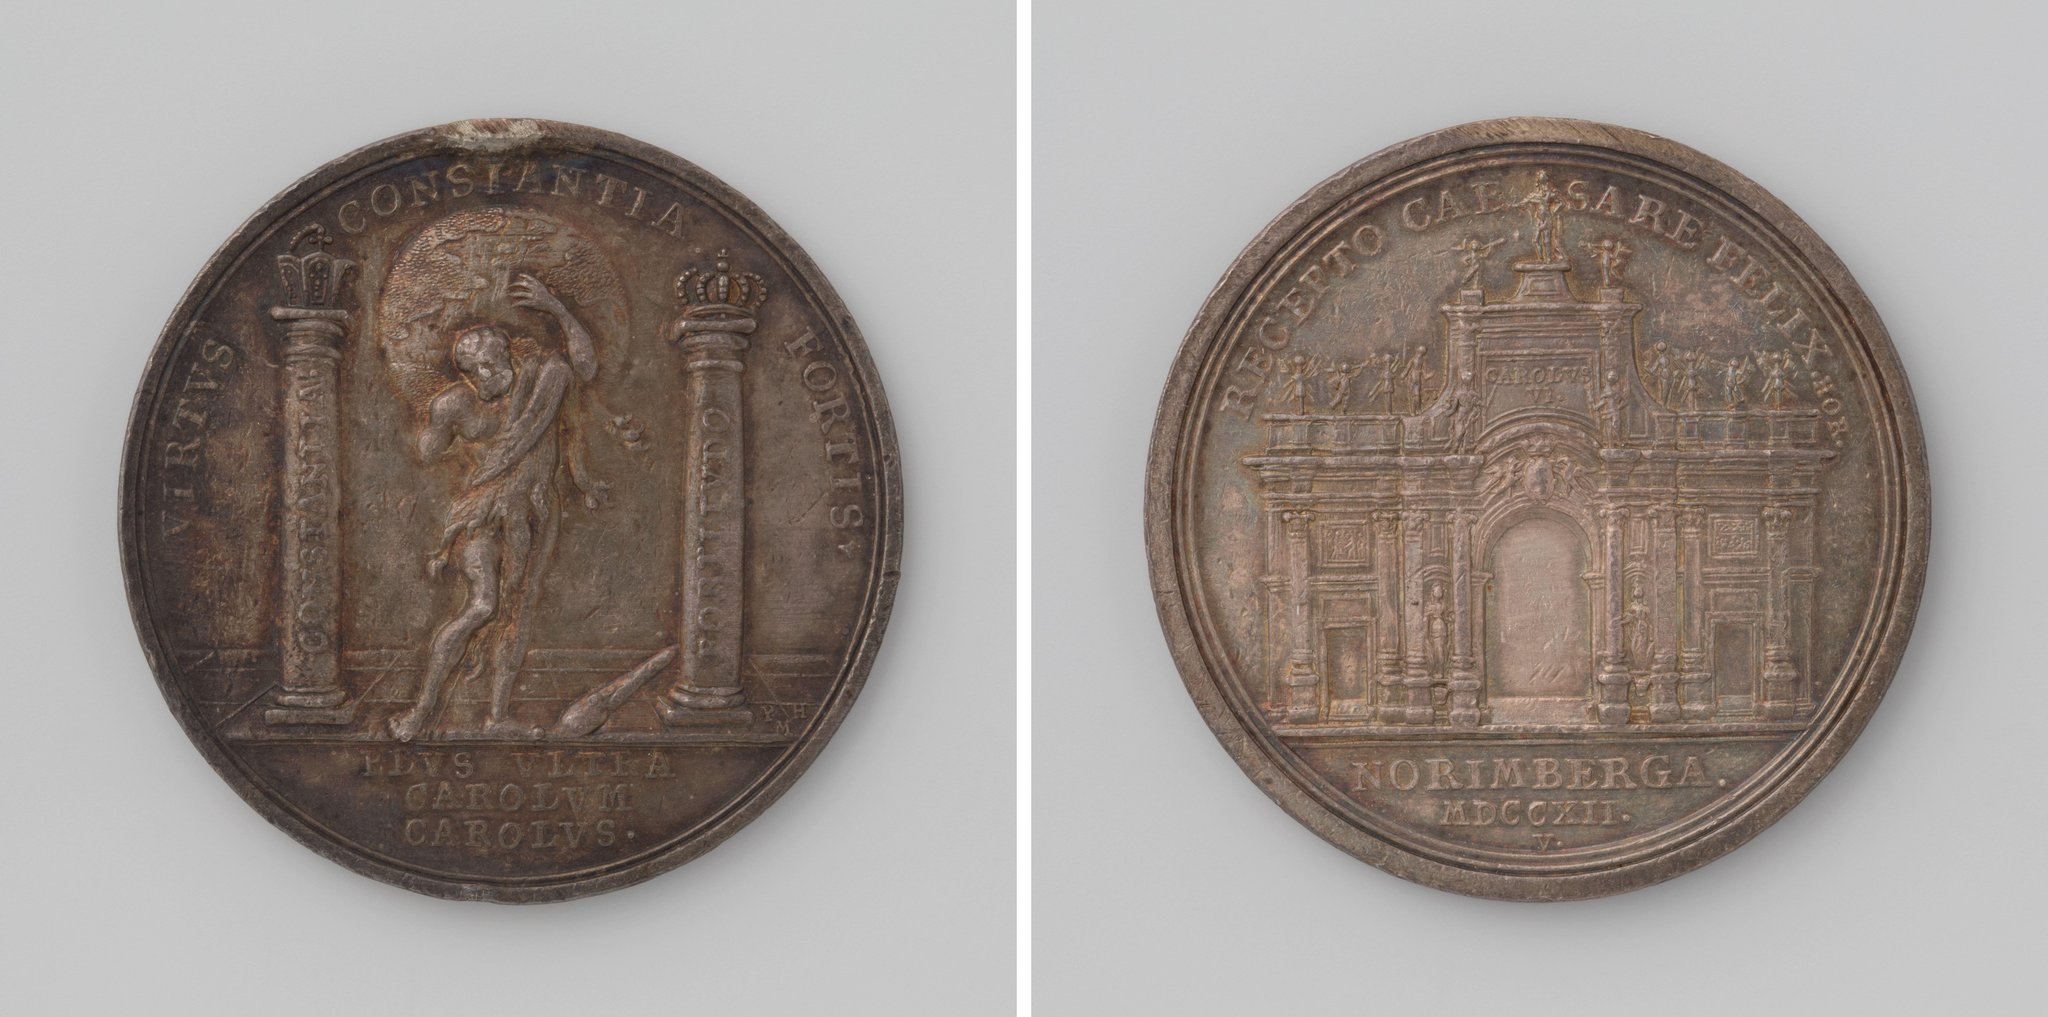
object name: history medal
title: Intocht van Karel VI te Neurenberg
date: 1712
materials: silver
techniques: striking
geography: nuremberg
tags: vienna, charles vi (holy roman emperor)